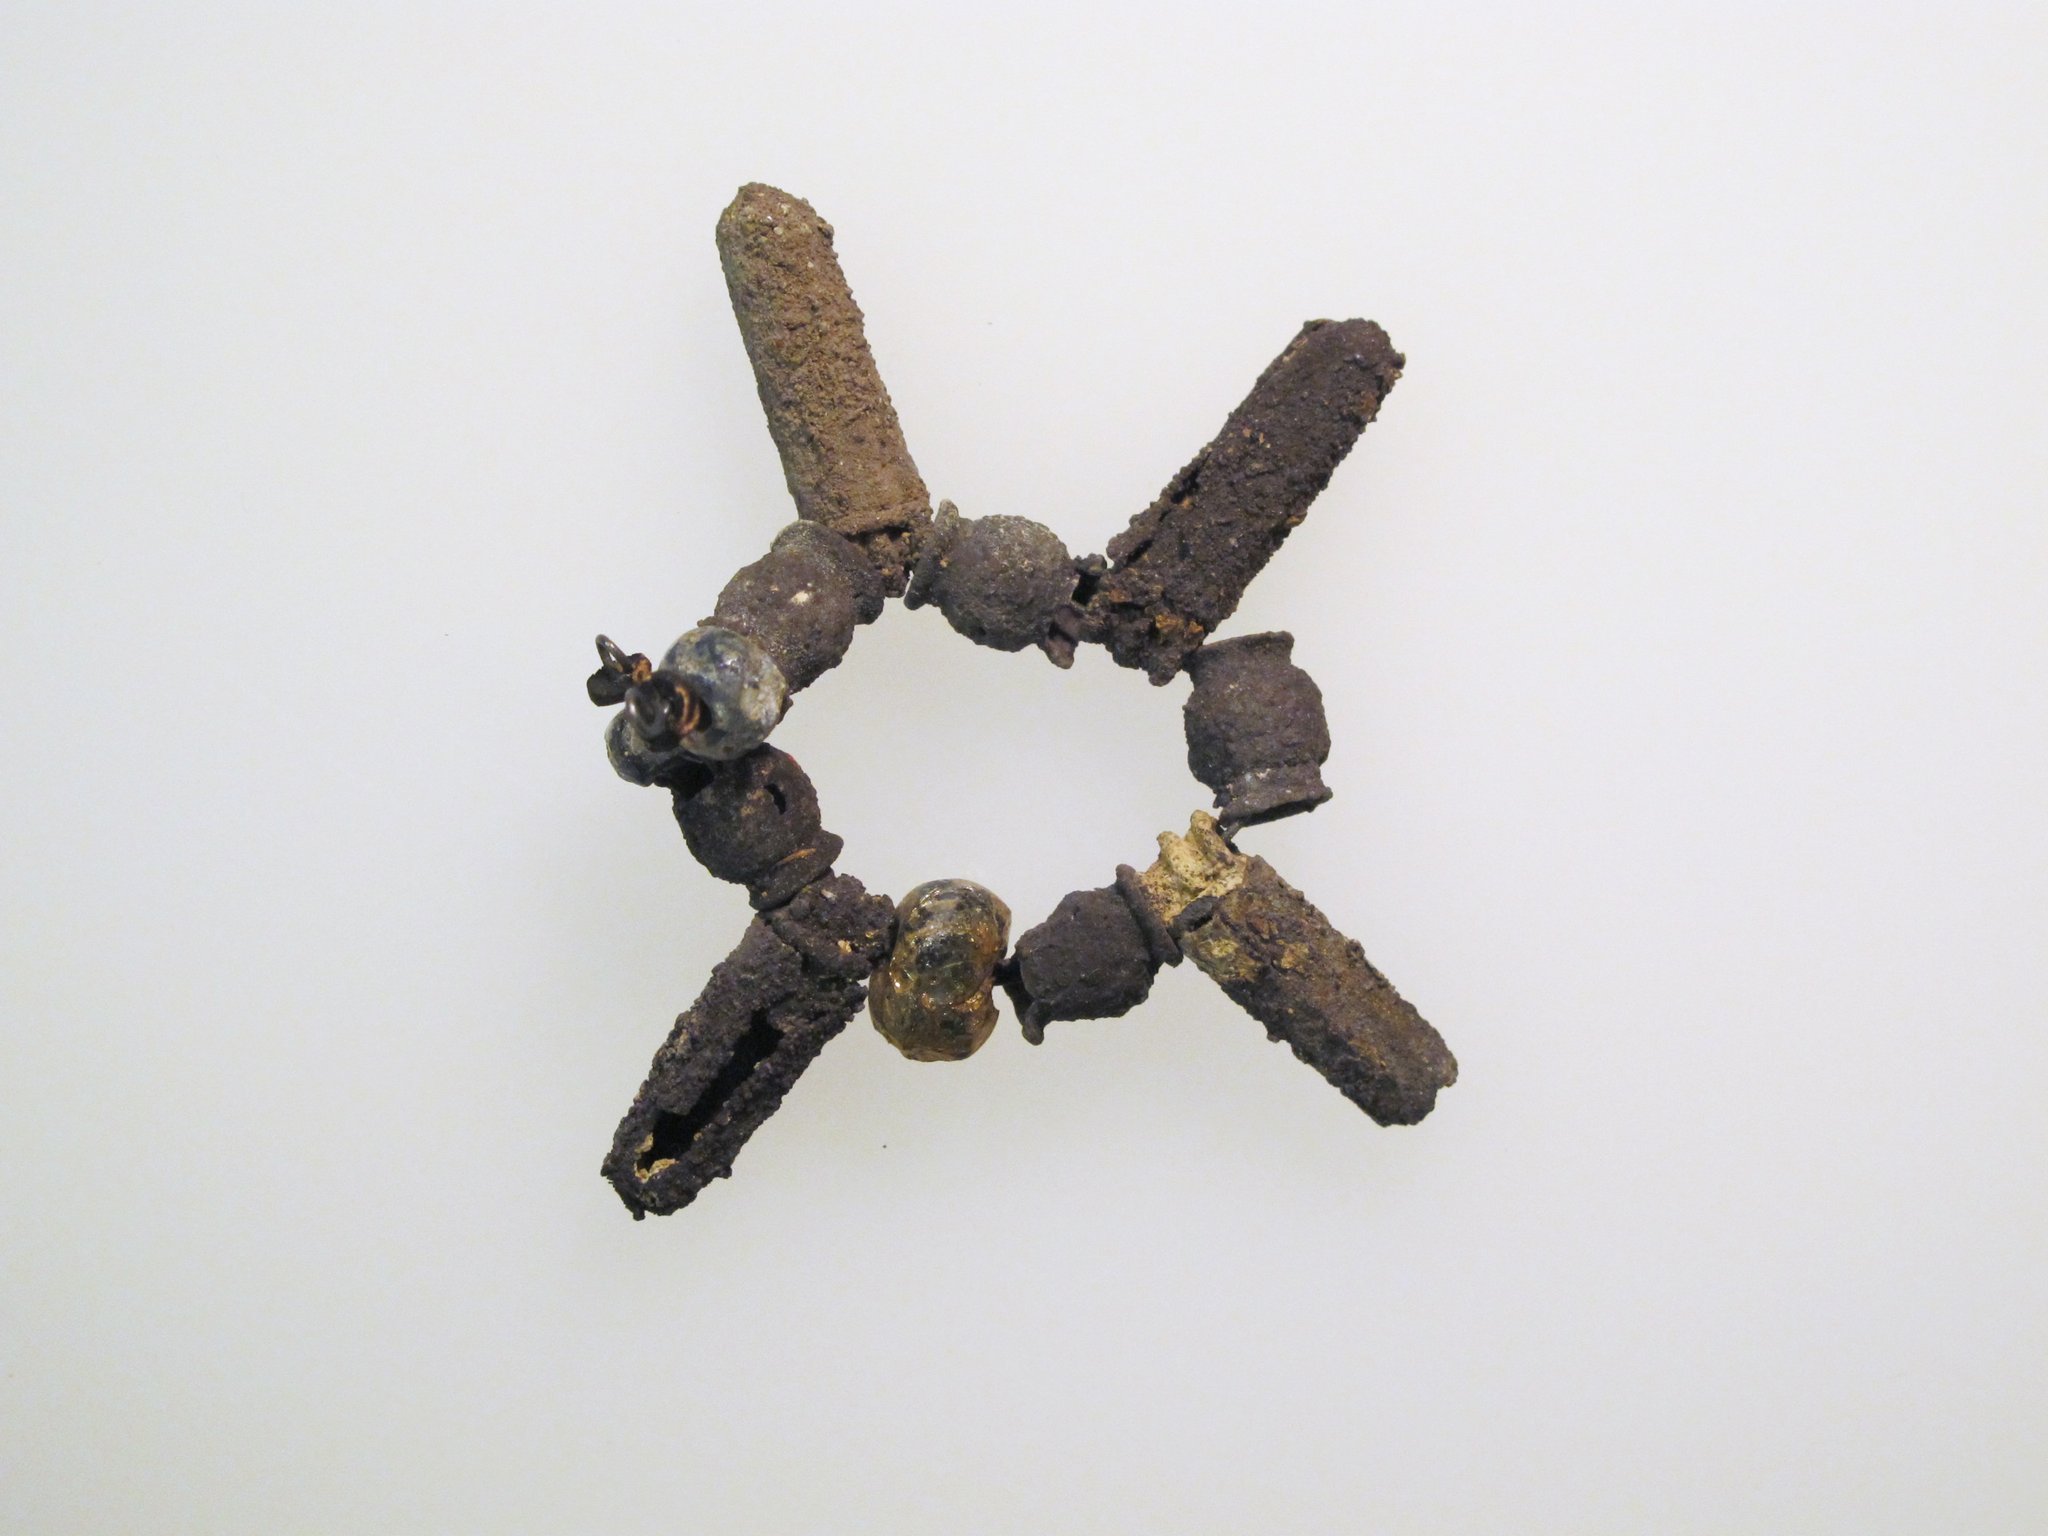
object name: bead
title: Beads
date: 7000 BCE-330 CE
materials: glass, silver